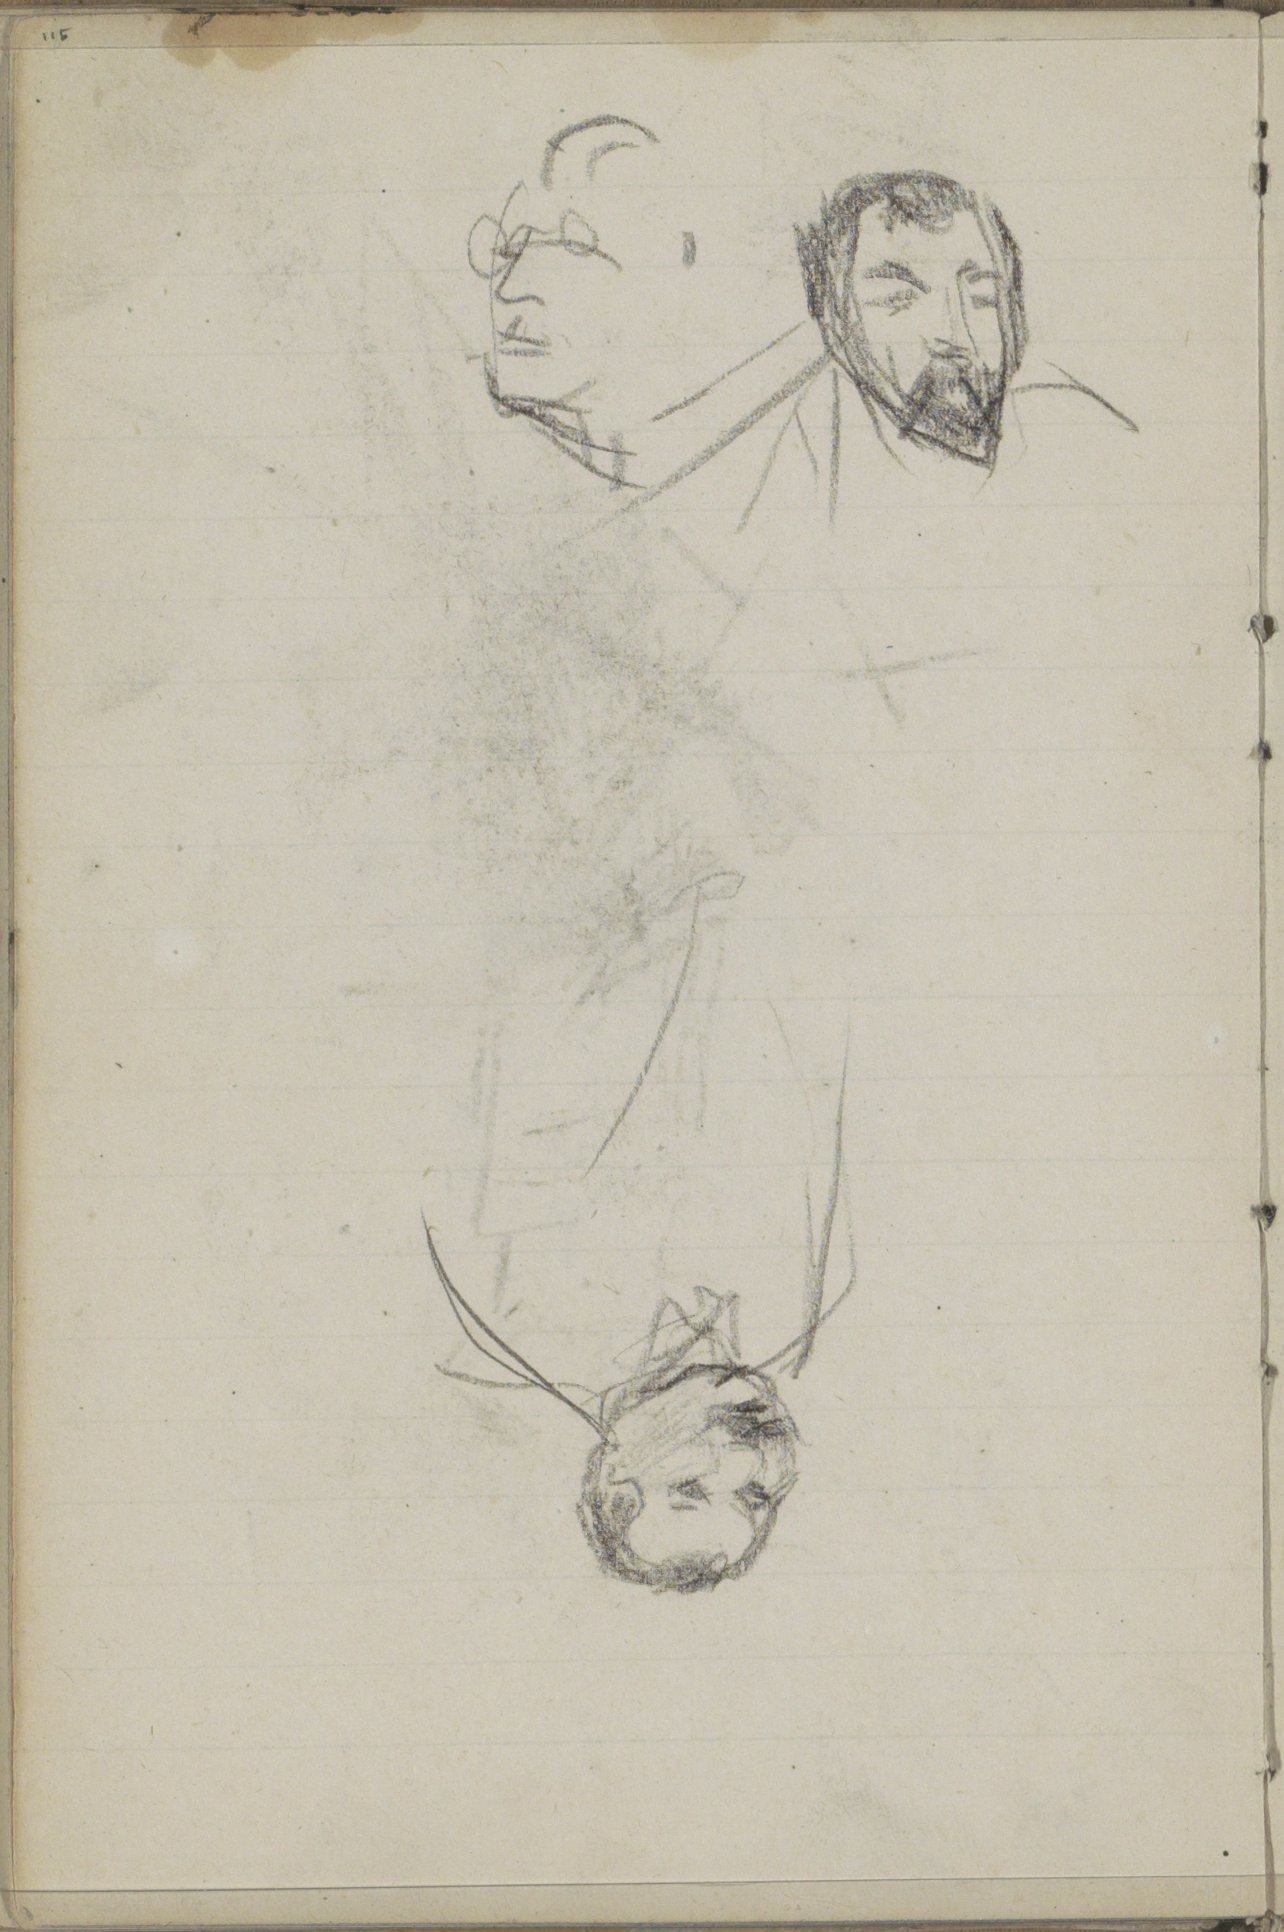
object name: sketchbook leaf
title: Drie mannenkoppen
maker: marius bauer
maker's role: draughtsman, print maker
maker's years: 1867-1932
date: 1888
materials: chalk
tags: head (human), adult man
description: Pagina 115 uit een schetsboek met 58 bladen.